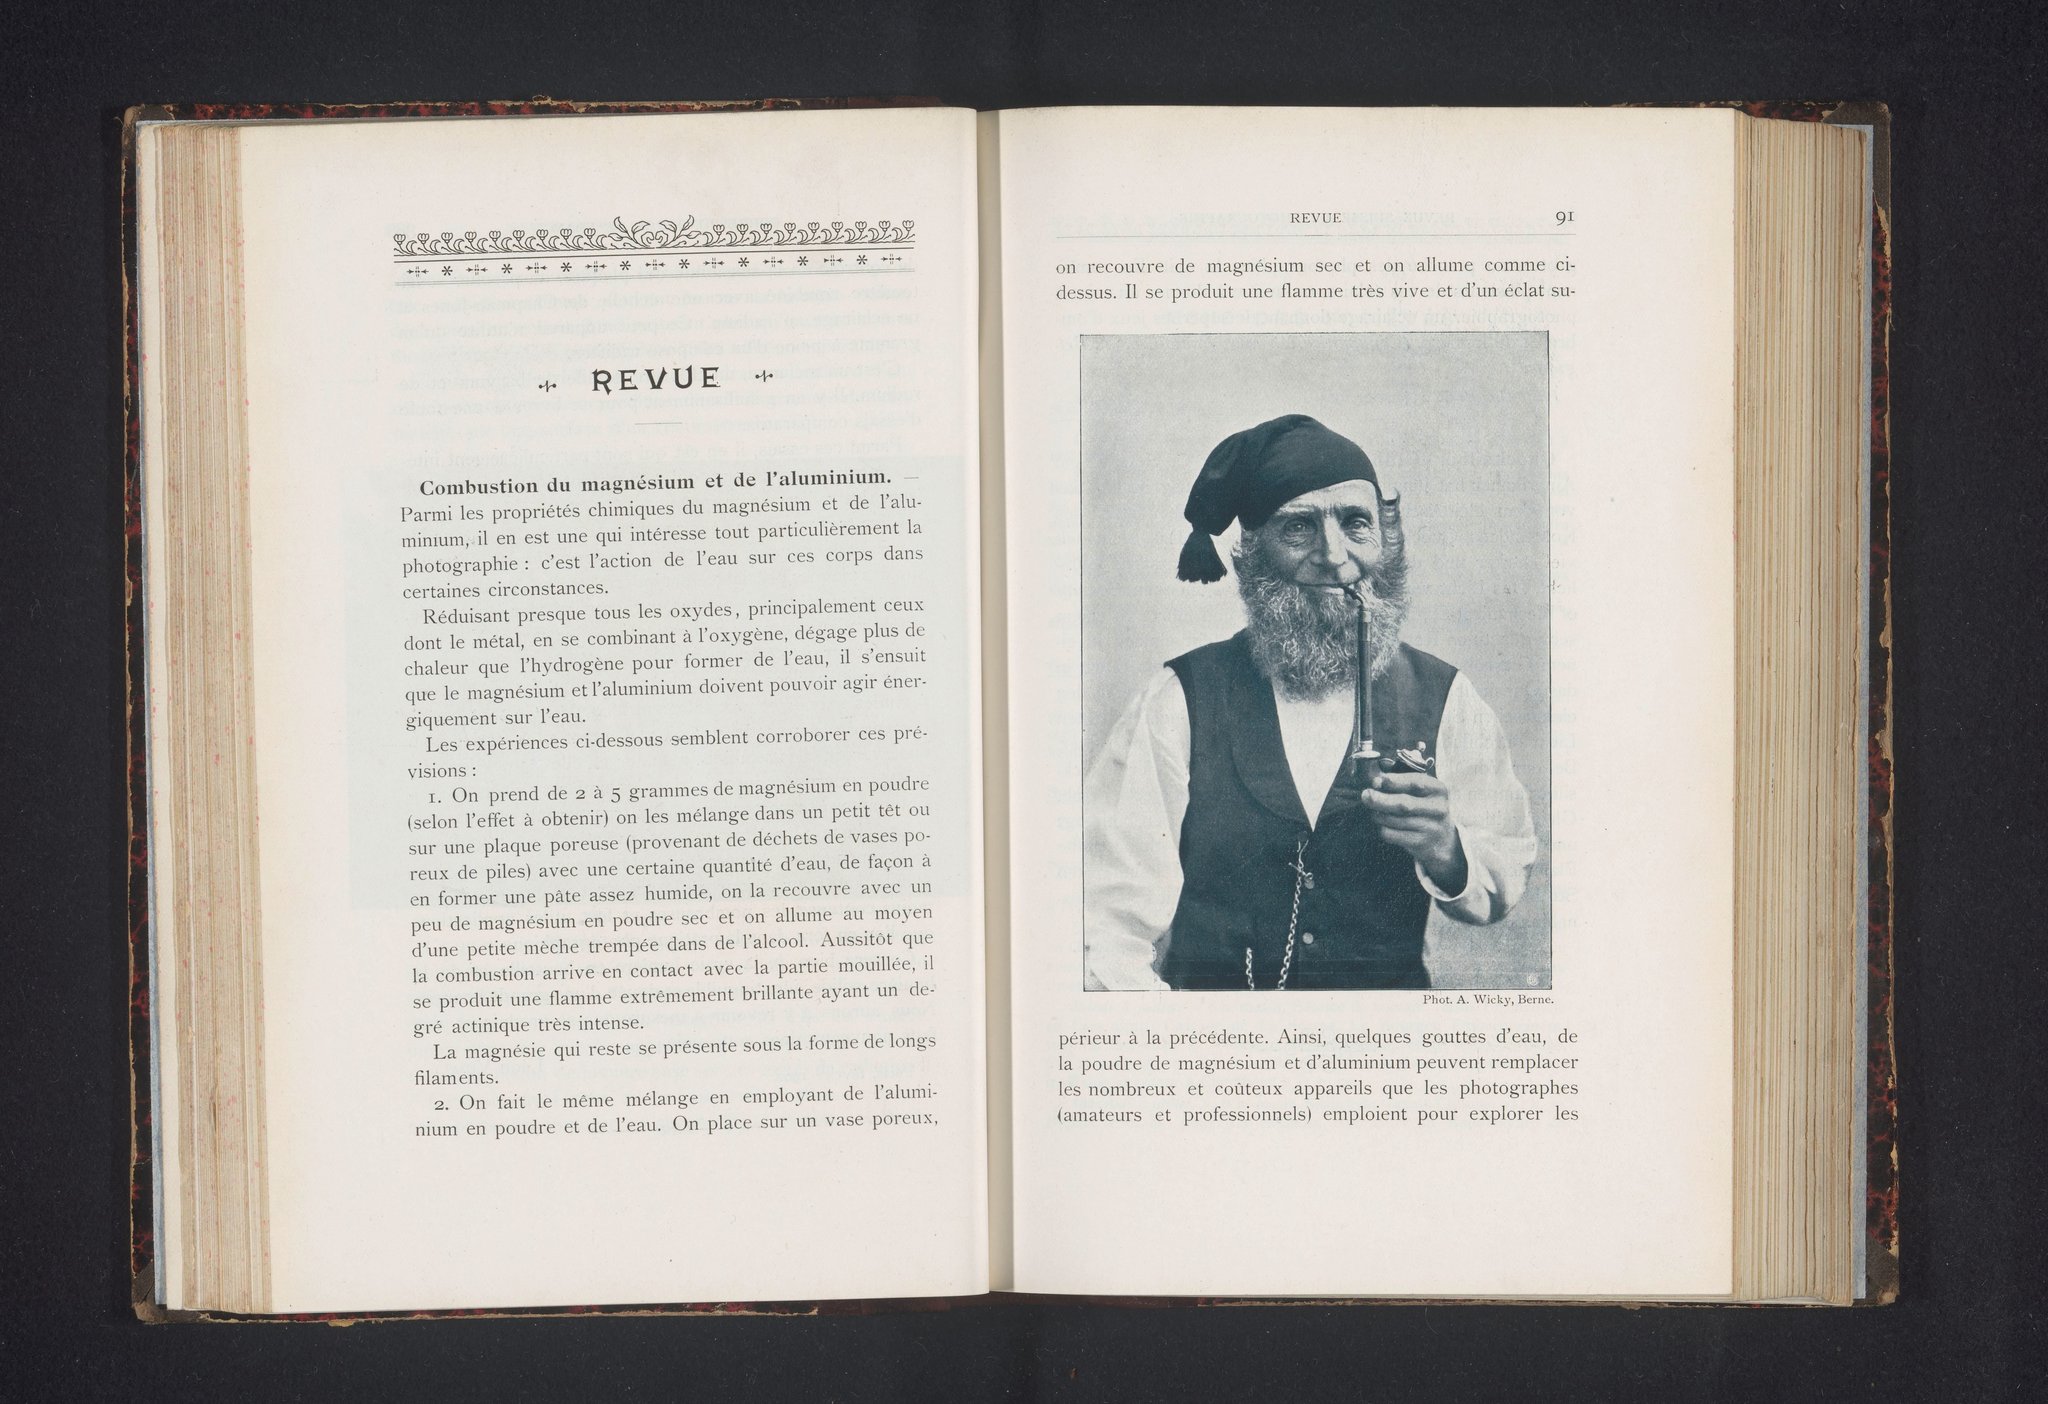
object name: photomechanical print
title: Portret van een onbekende man die pijp rookt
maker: a. wicky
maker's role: fotograaf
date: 1897-1902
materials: paper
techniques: autotype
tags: historical persons, pipe ~ tobacco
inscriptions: monogram: ‘C. Cie’